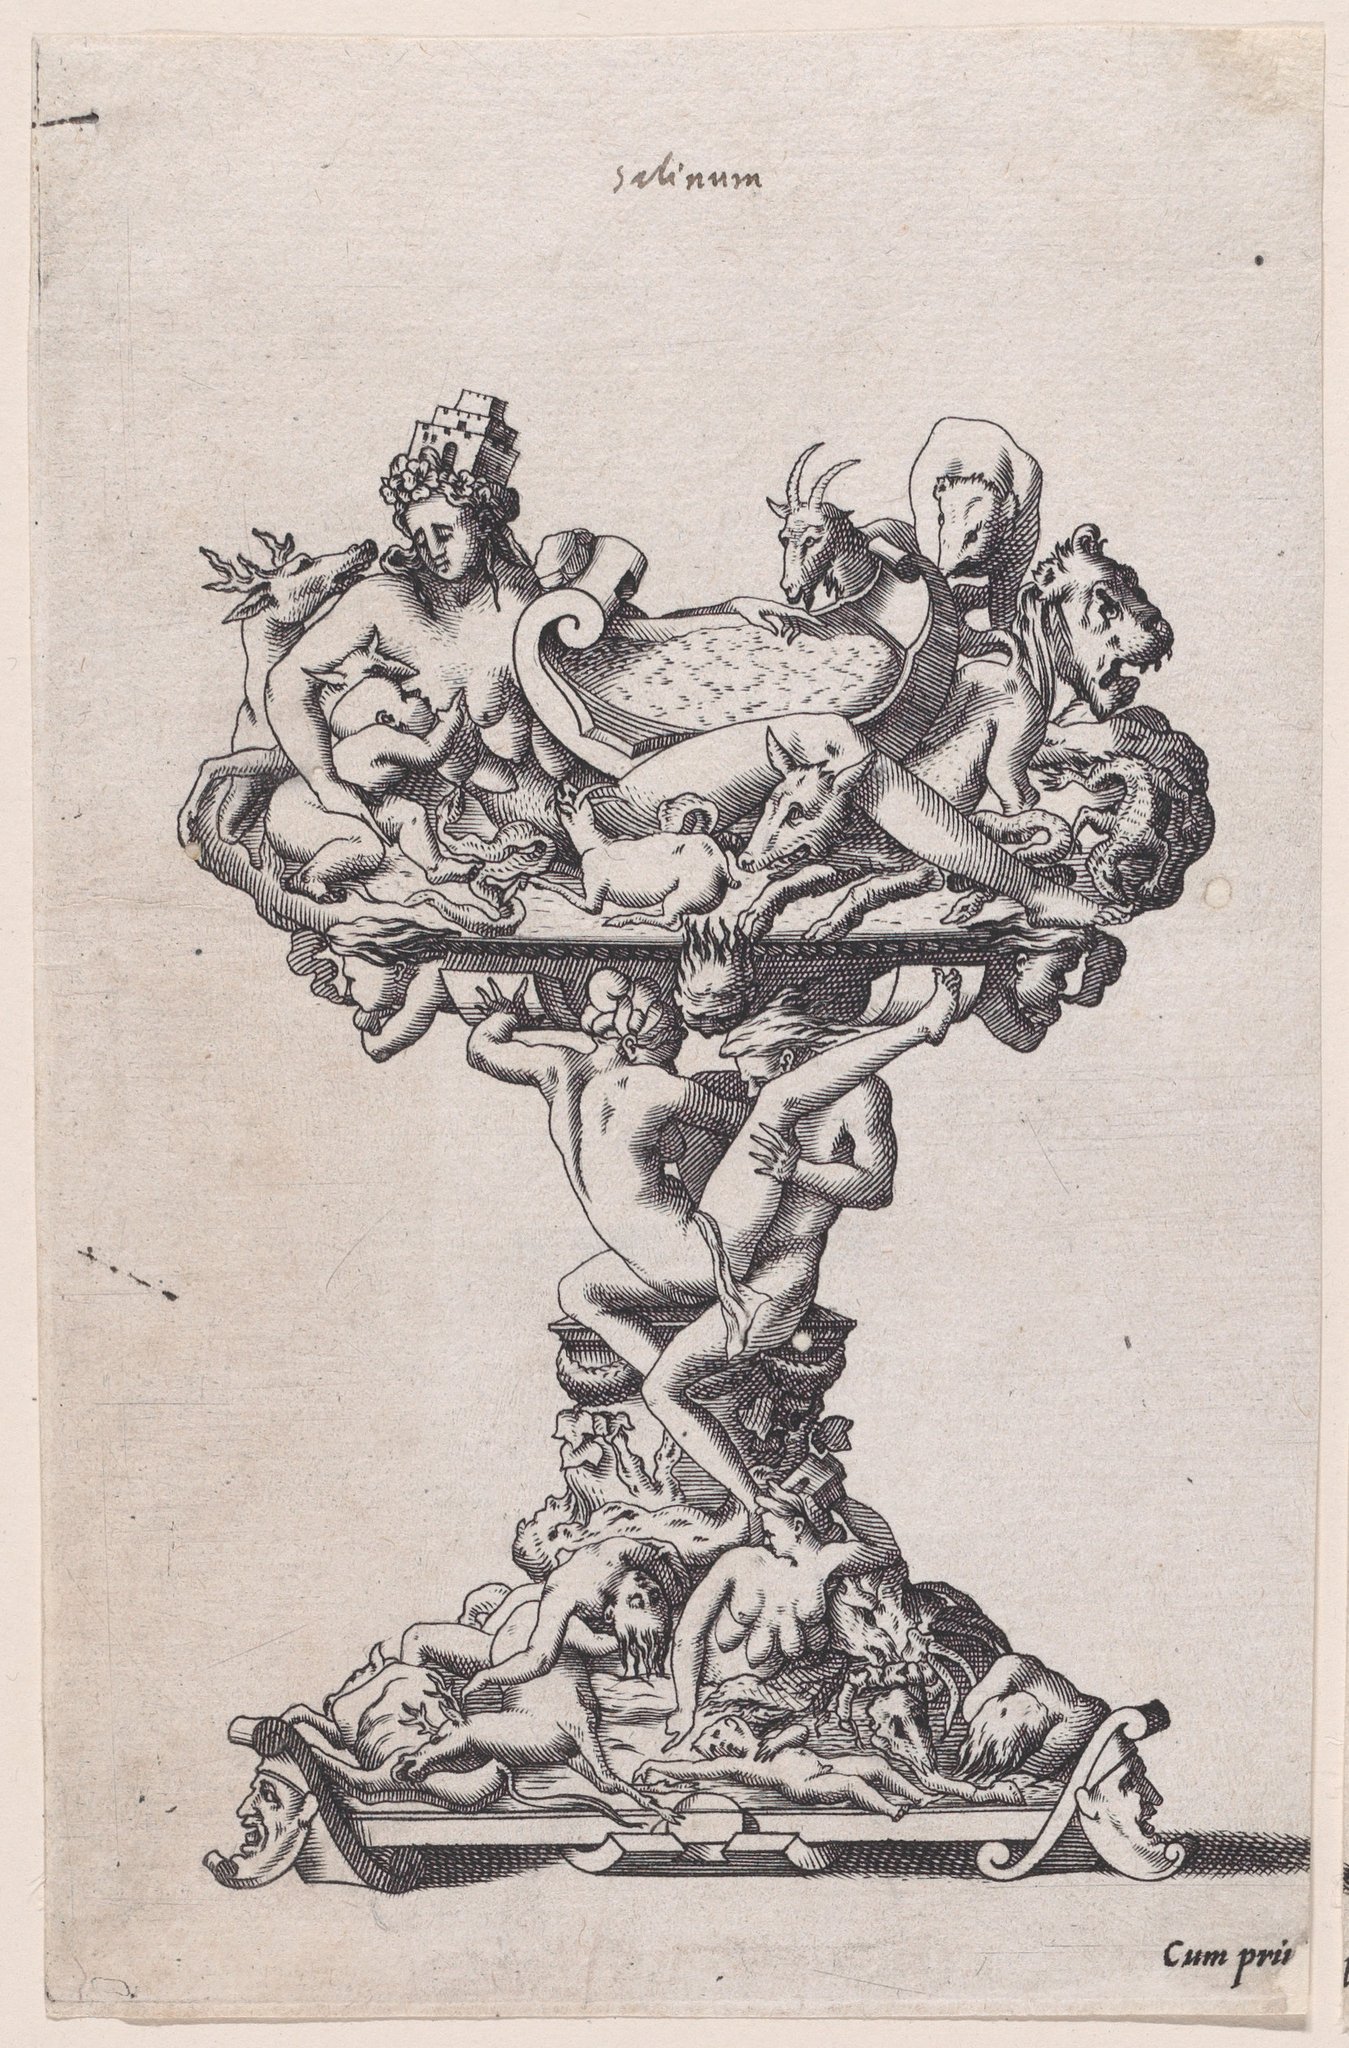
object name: print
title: Salt-cellar with Cybèle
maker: rené boyvin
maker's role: artist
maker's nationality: french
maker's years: 1525-1598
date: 1525-1600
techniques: engraving